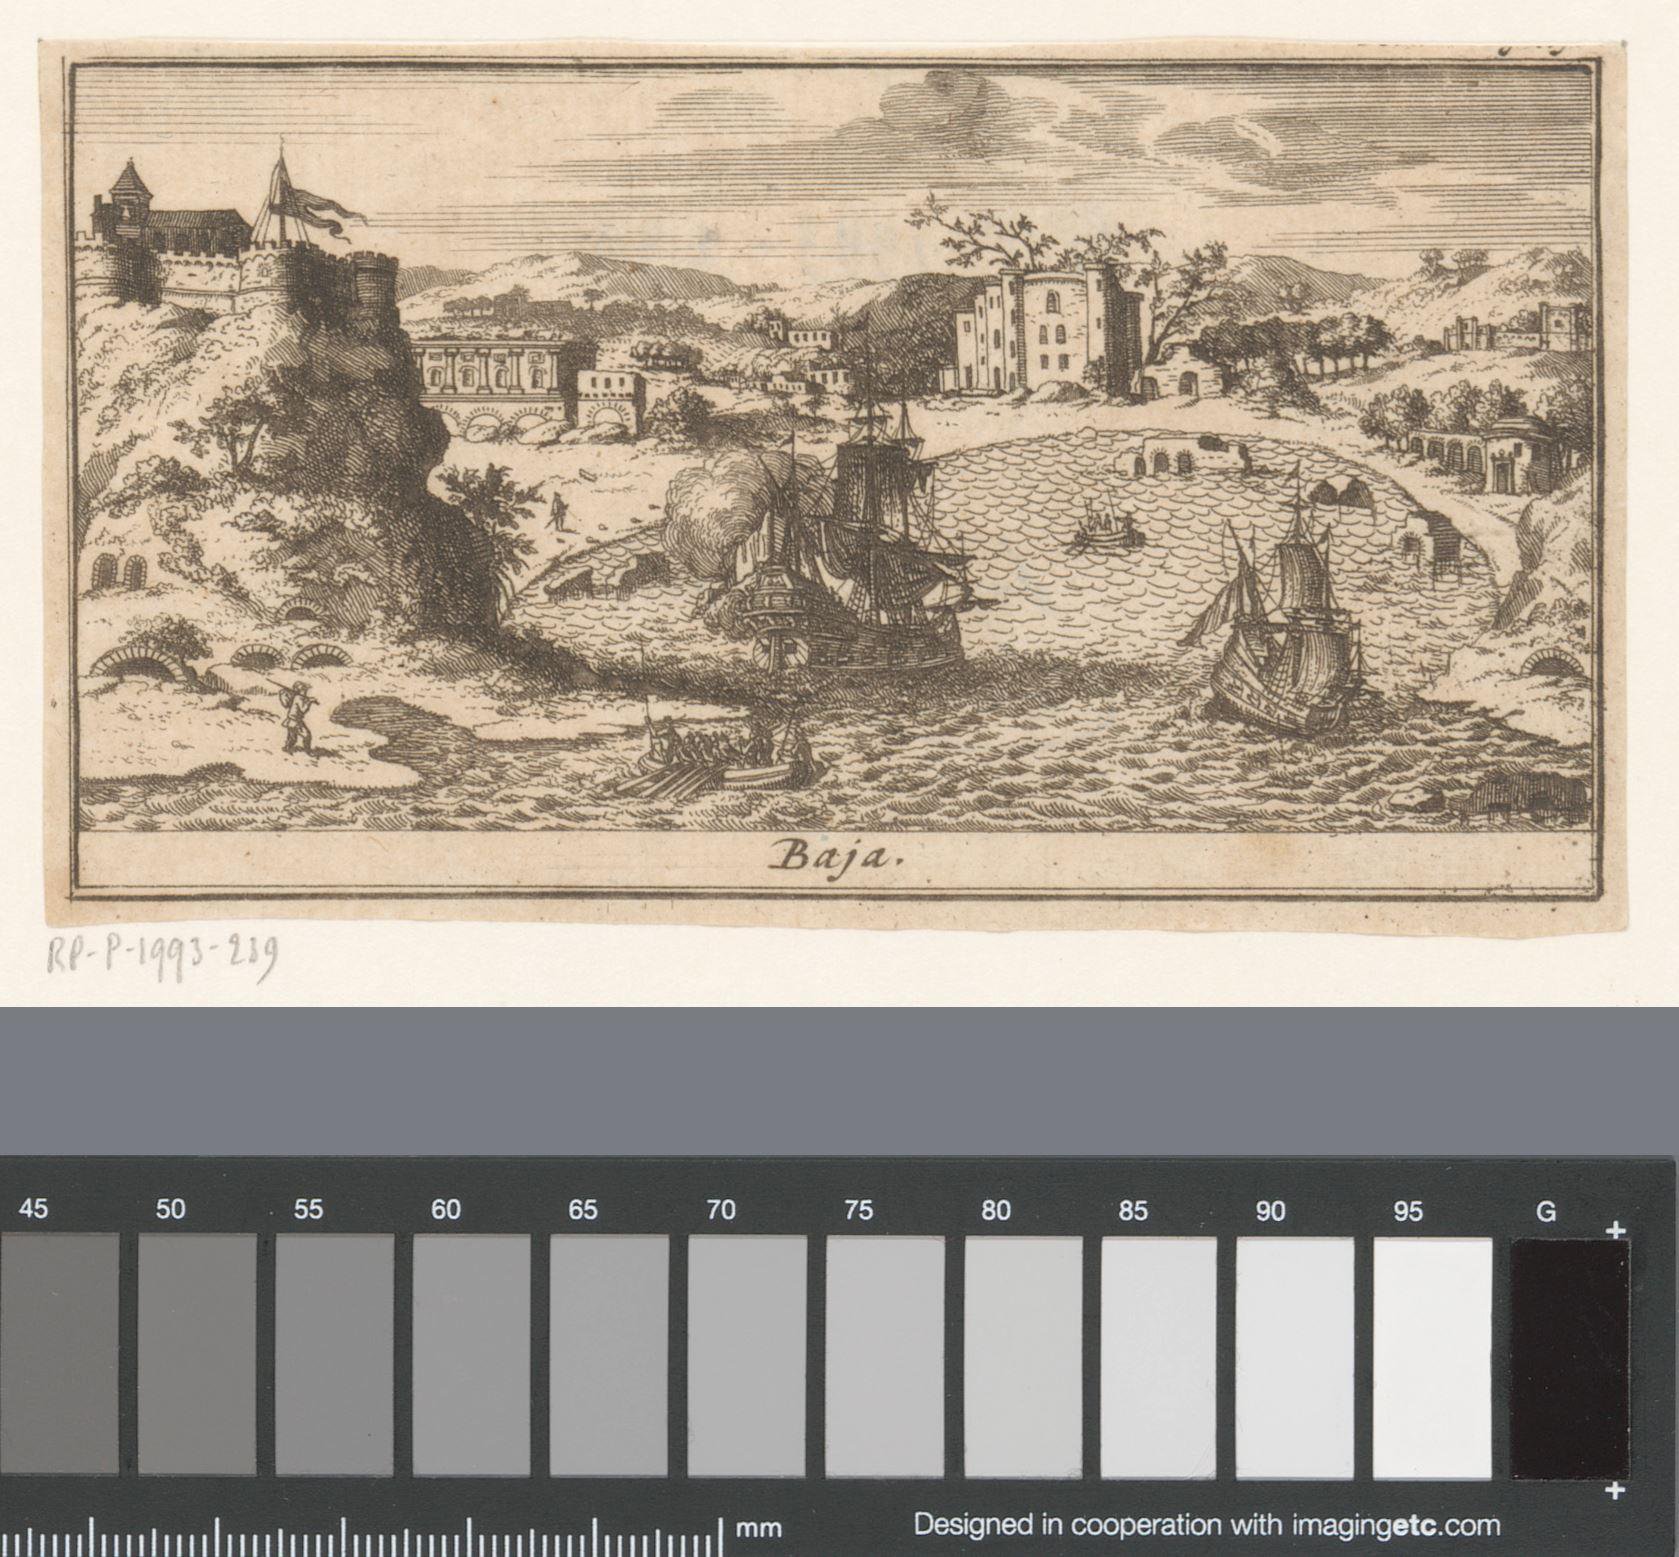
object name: print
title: Baja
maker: pieter van der aa (i)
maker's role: printer, publisher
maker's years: 1659-1733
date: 1682-1730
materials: paper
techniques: etching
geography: leiden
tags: gulf, bay, fortress, sailing-ship, sailing-boat, landscapes, coast, naples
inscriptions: collector's mark: Lugt 2228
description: Gezicht op de baai van Napels. Een baai met zeilschepen en op de achtergrond enkele forten.